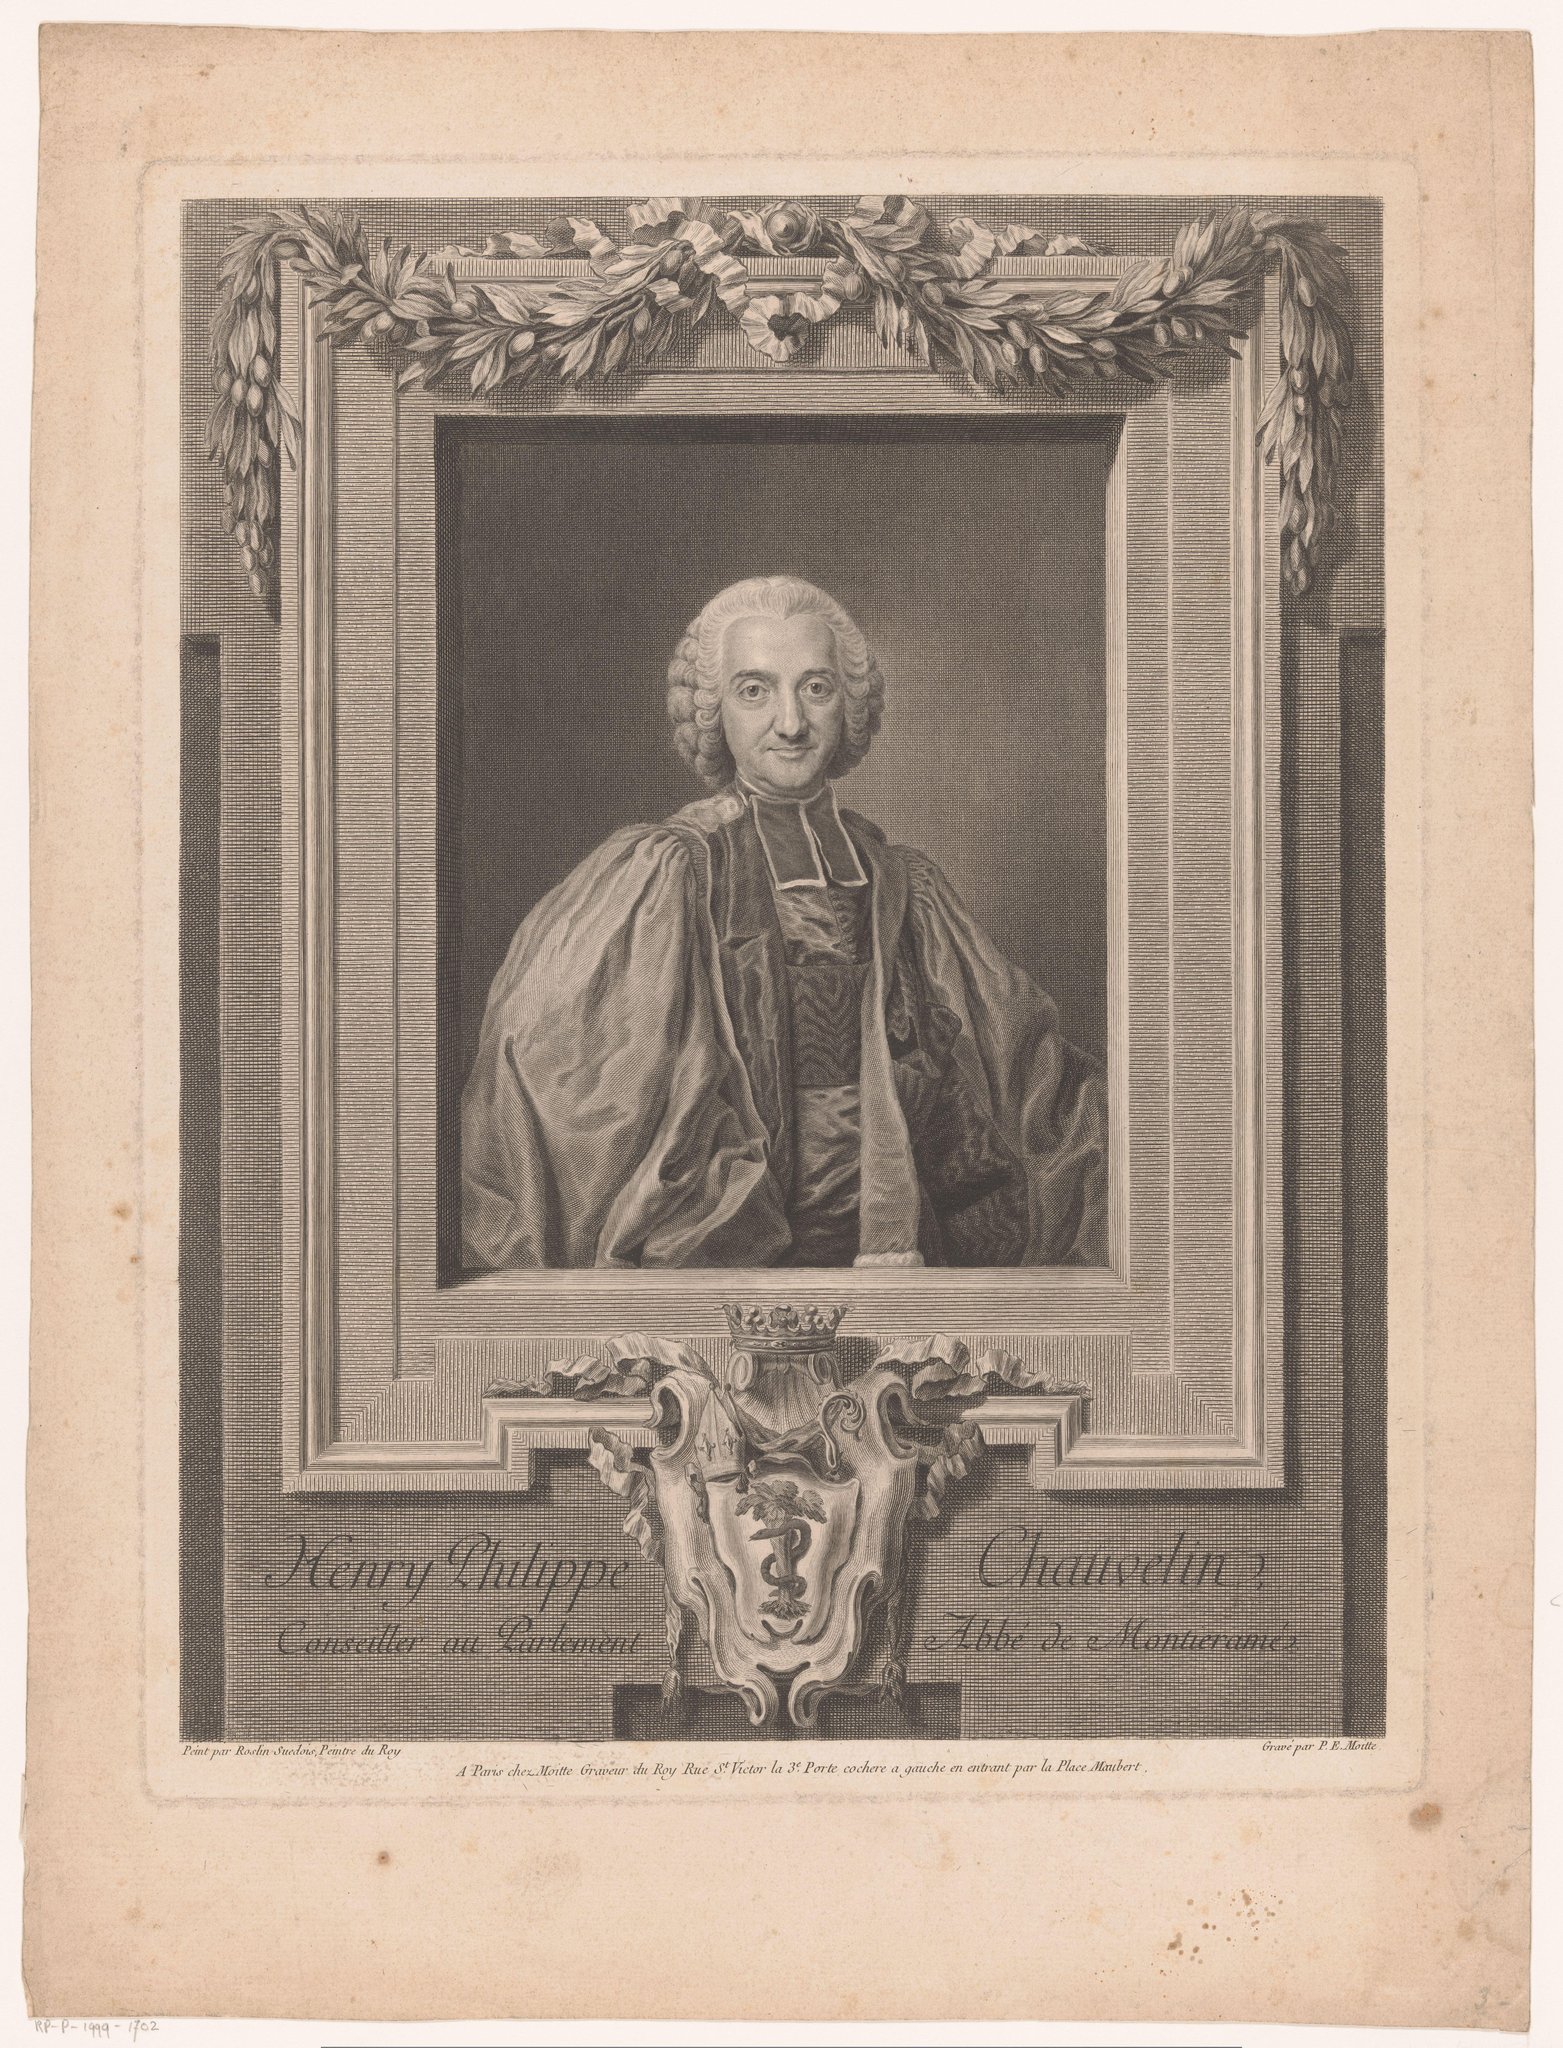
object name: print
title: Portret van Henry-Philippe Chauvelin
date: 1750-1780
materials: paper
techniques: engraving, etching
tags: priest, historical persons, armorial bearing, heraldry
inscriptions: collector's mark: Lugt 2228